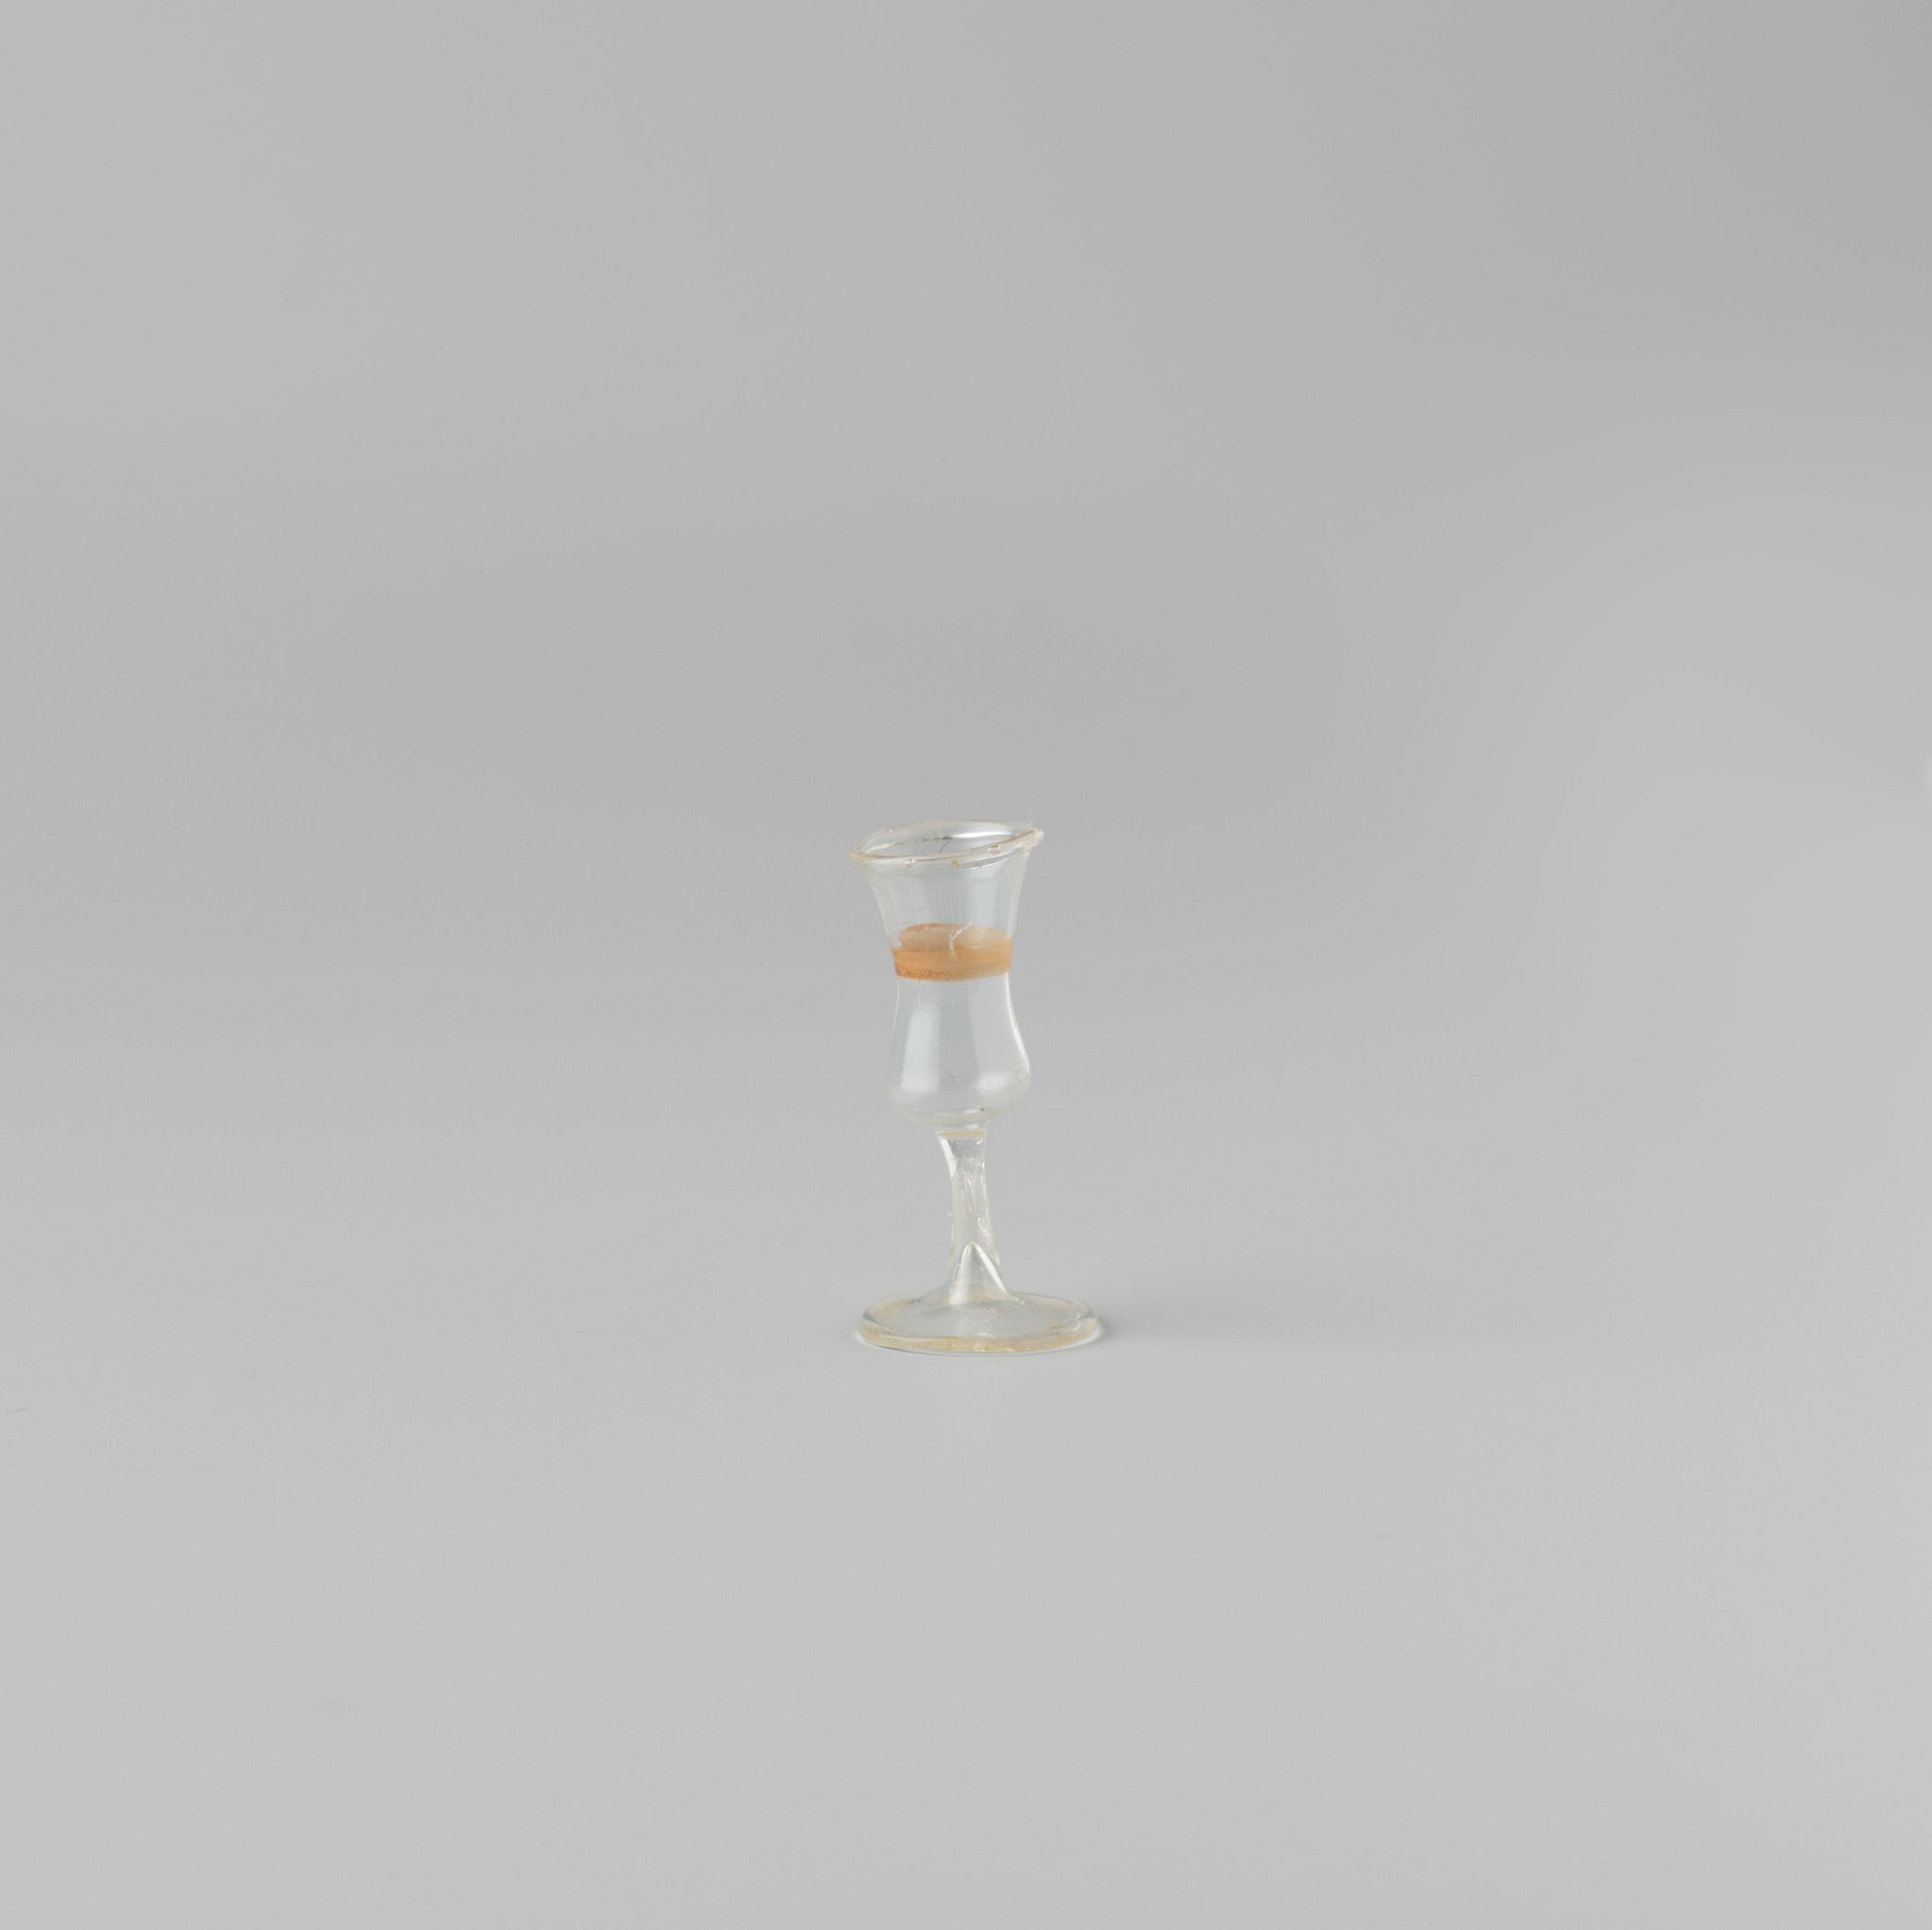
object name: miniature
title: Kelkglas, met klokvormige kelk versierd met goudkleurige band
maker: Anonymous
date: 1800-1849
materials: glass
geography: bristol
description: Kelkglas van helder, kleurloos glas, klokvormige kelk met dikke mondrand, versierd met goudkleurige band, op massieve stam en iets oplopende voet.